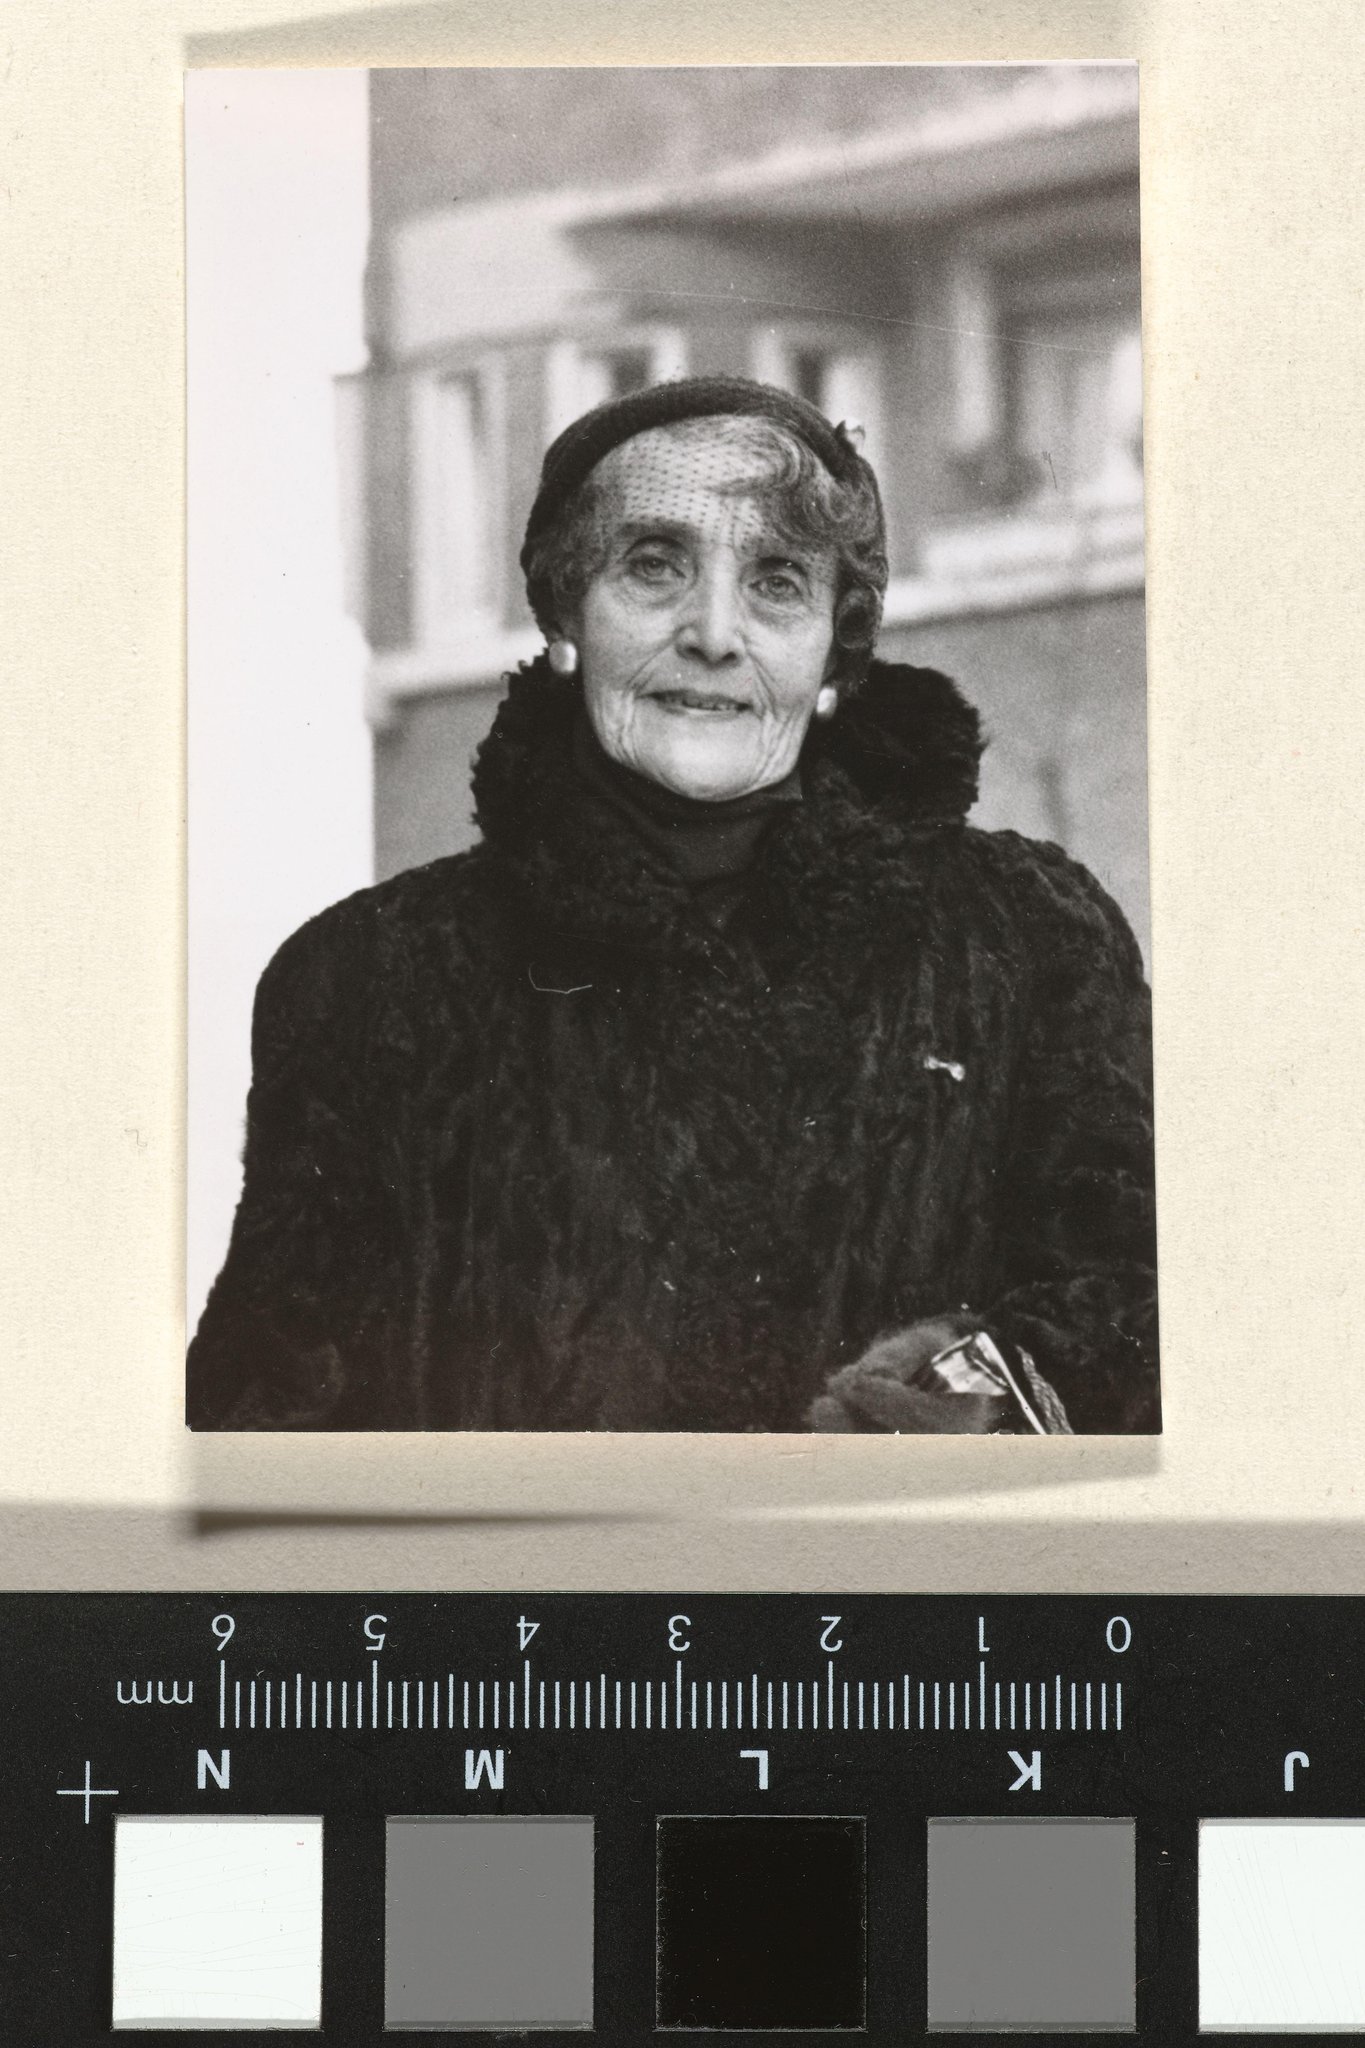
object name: photograph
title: Else Mauhs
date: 1900-1959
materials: photographic support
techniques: gelatin silver print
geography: amsterdam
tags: amsterdam, historical persons - bb - woman